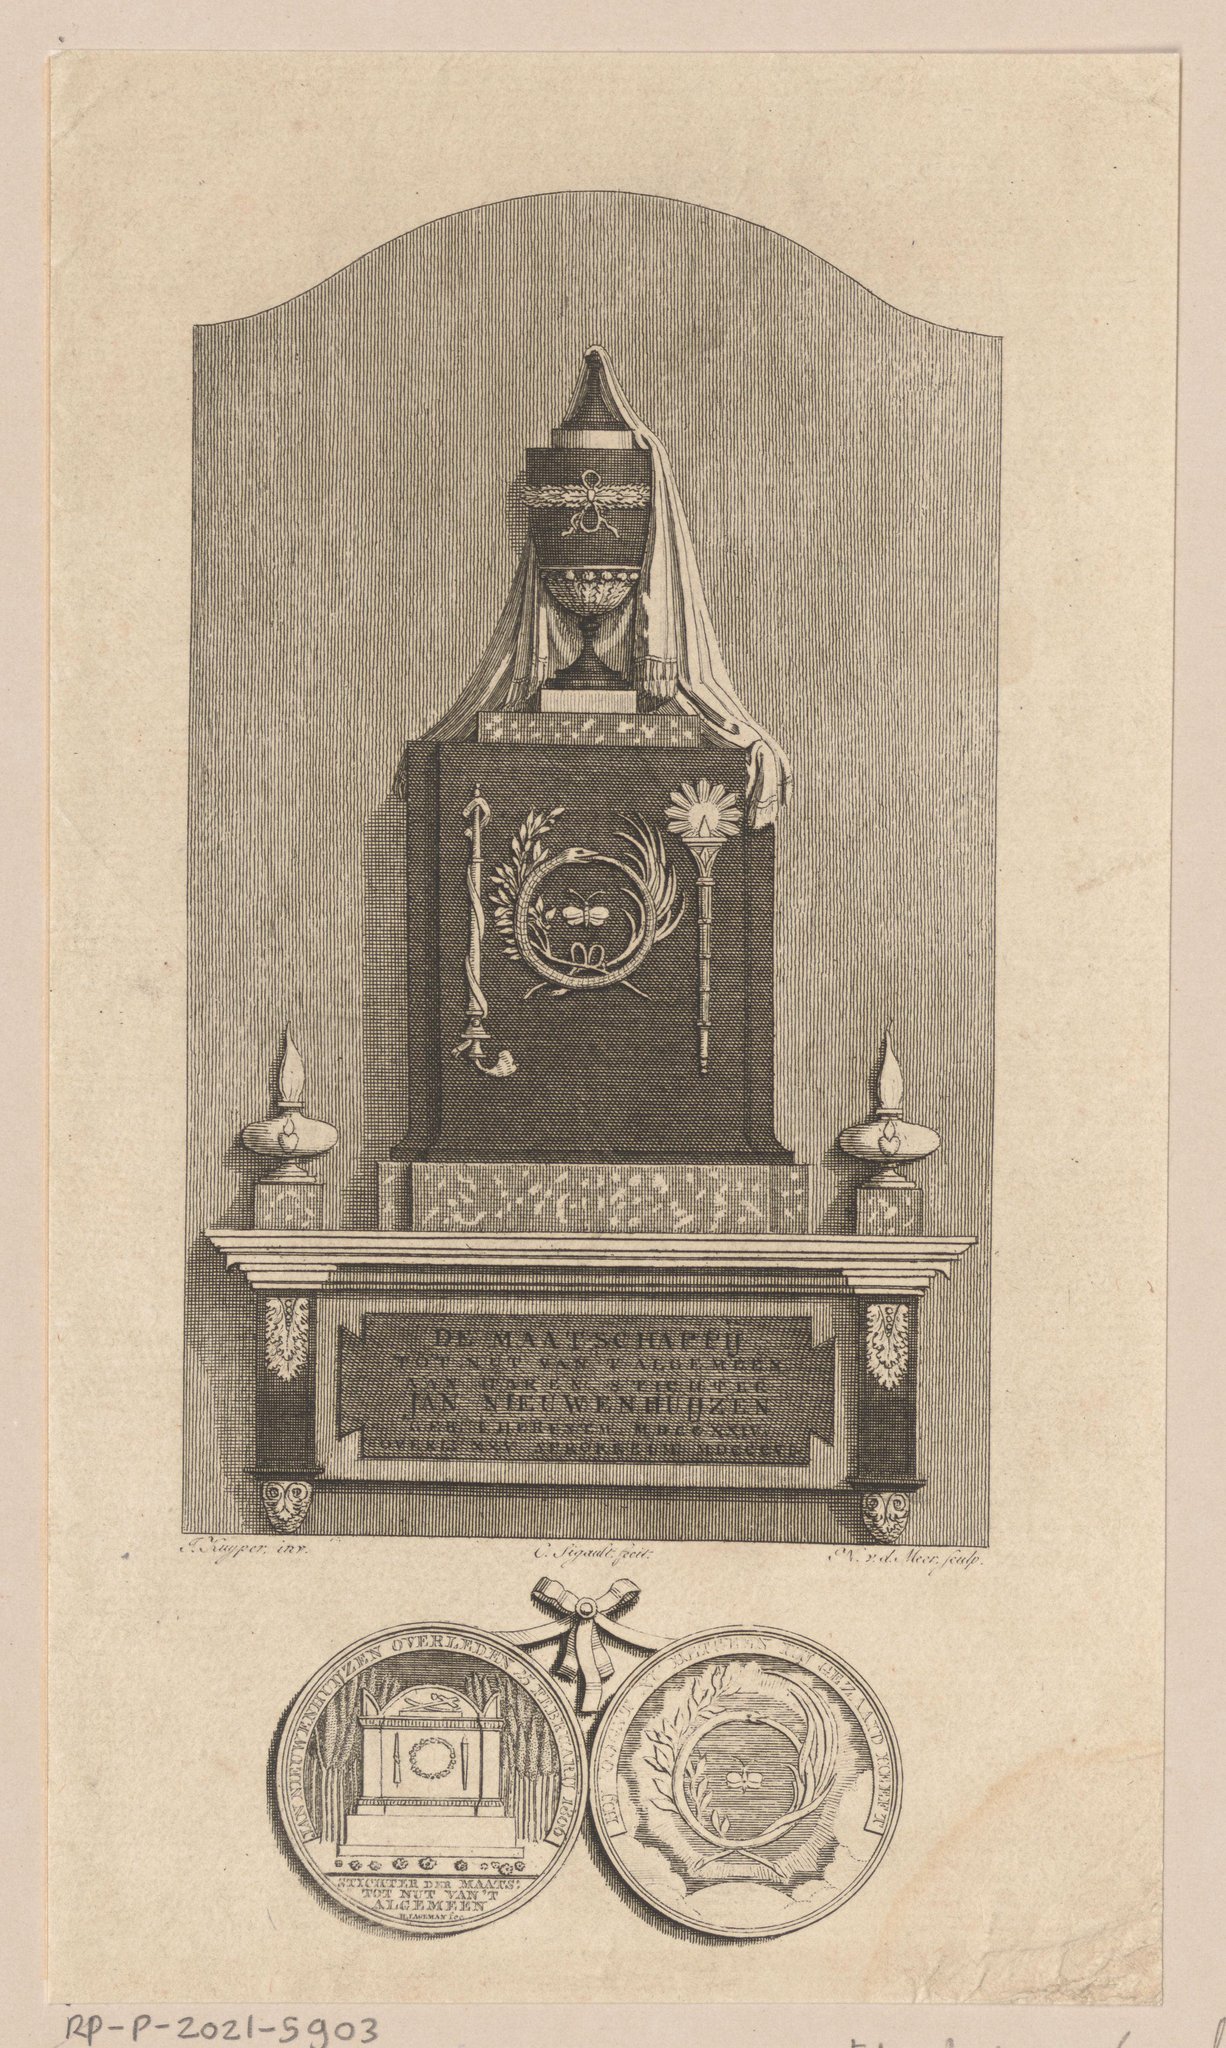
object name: print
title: Grafmonument voor Jan Nieuwenhuyzen in de Grote Kerk te Monnickendam en penning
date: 1806-1822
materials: paper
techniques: etching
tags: haarlem, amsterdam, jan nieuwenhuyzen, historical persons, memorial medal, other memorial structures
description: Gedenkzuil voor Jan Nieuwenhuyzen. In het midden een omgekeerde fakkel, een slang die in zijn eigen staart bijt als eeuwigheidsymbool en een brandende fakkel. Onderaan de voor- en achterzijde van een gedenkpenning, die ter gelegenheid van de dood van Nieuwenhuyzen werd vervaardigd.